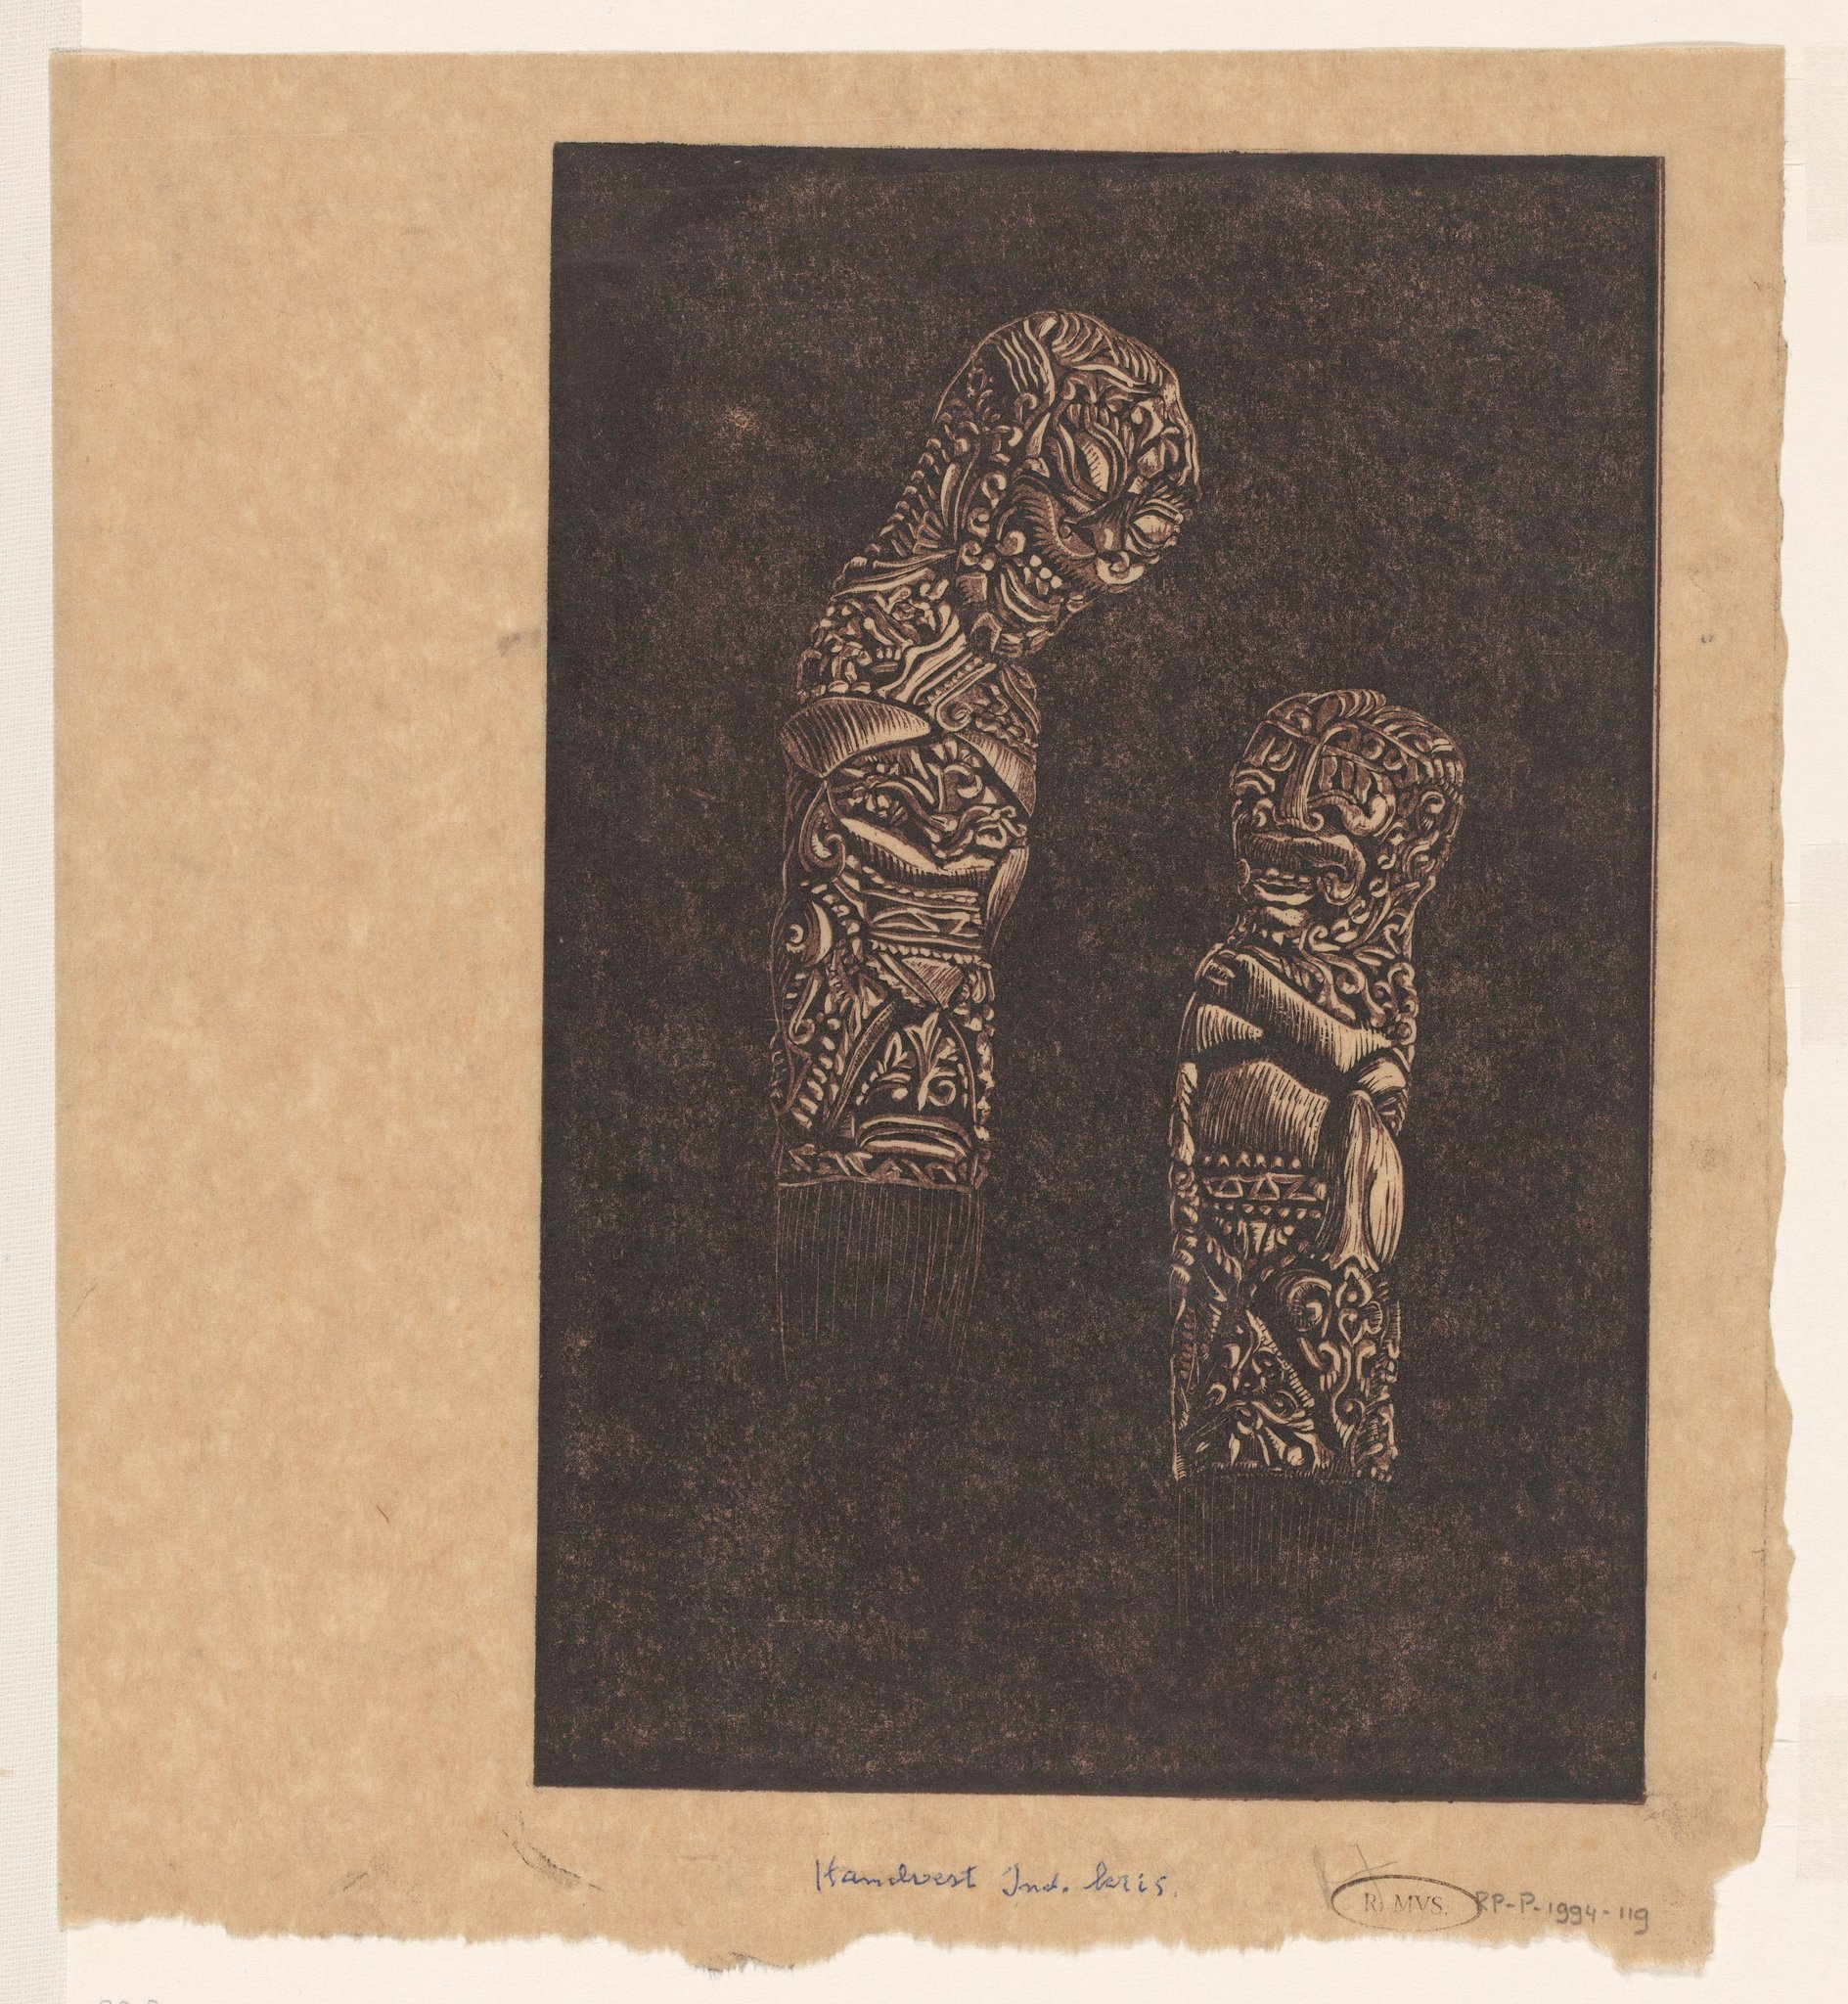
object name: print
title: Handvest Ind. kris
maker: reijer stolk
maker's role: draughtsman, print maker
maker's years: 1896-1945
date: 1906-1945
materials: paper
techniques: woodcut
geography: netherlands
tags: parts of hacking and thrusting weapons: grip, indonesia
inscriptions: collector's mark: Lugt 2228